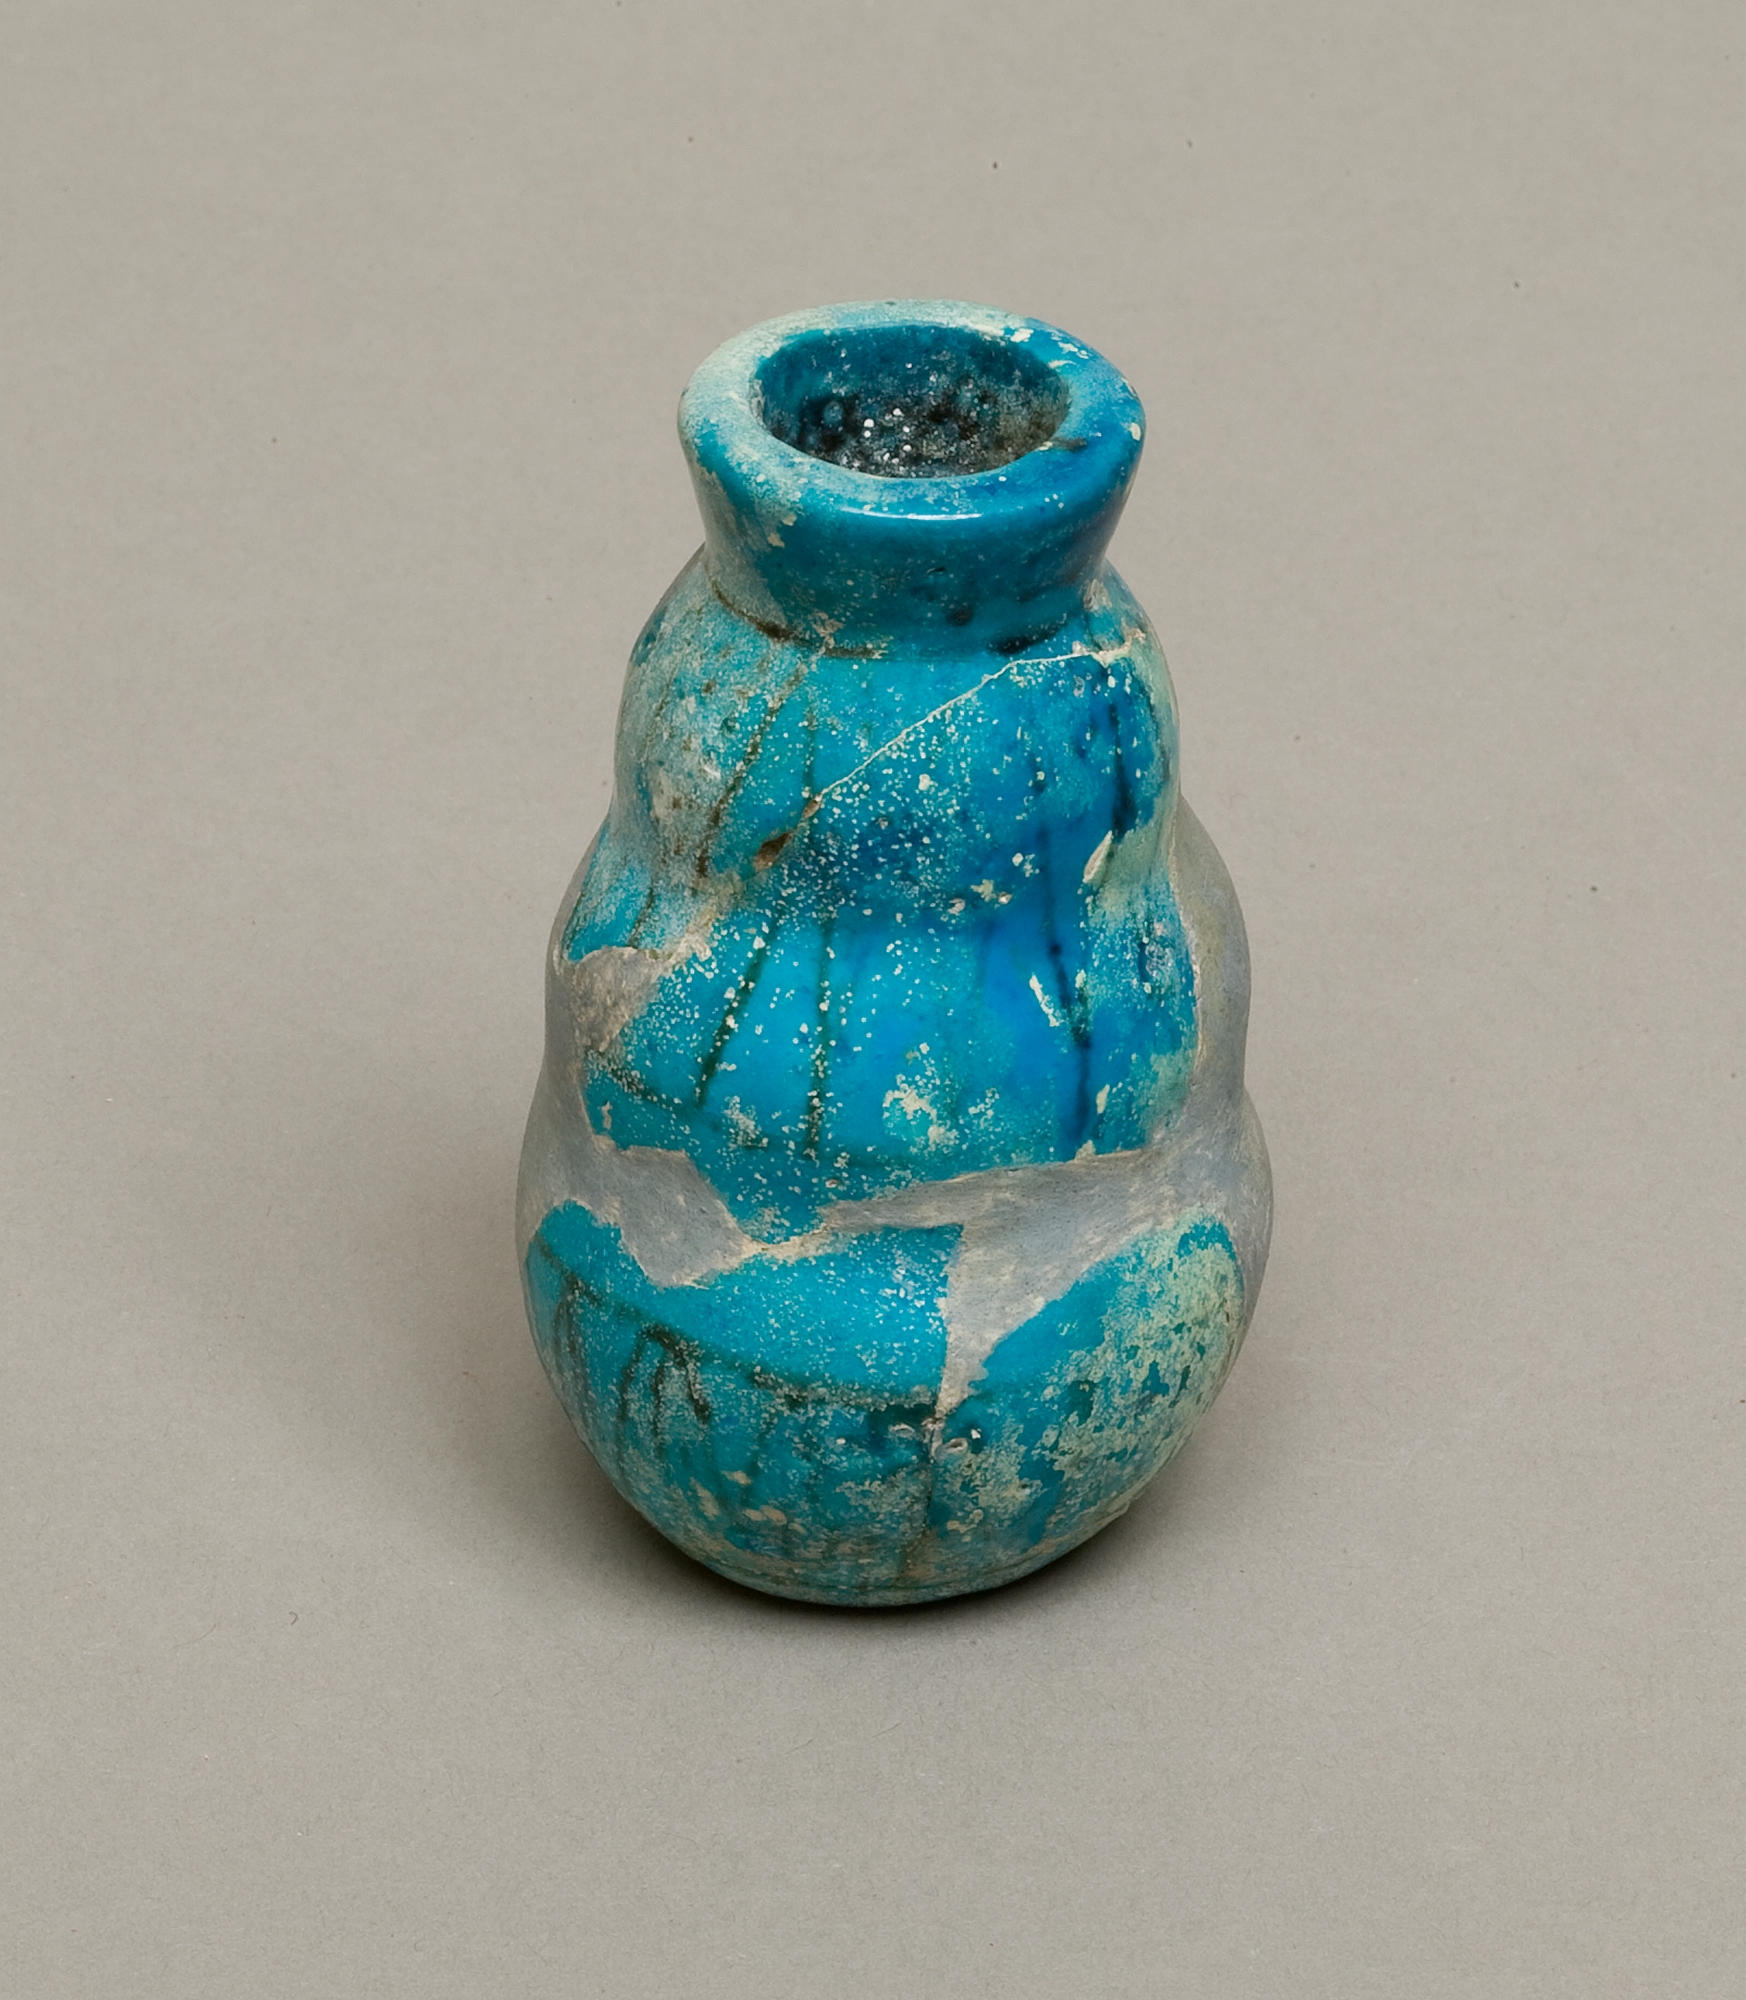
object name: jar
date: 1981-1640 BCE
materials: faience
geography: egypt